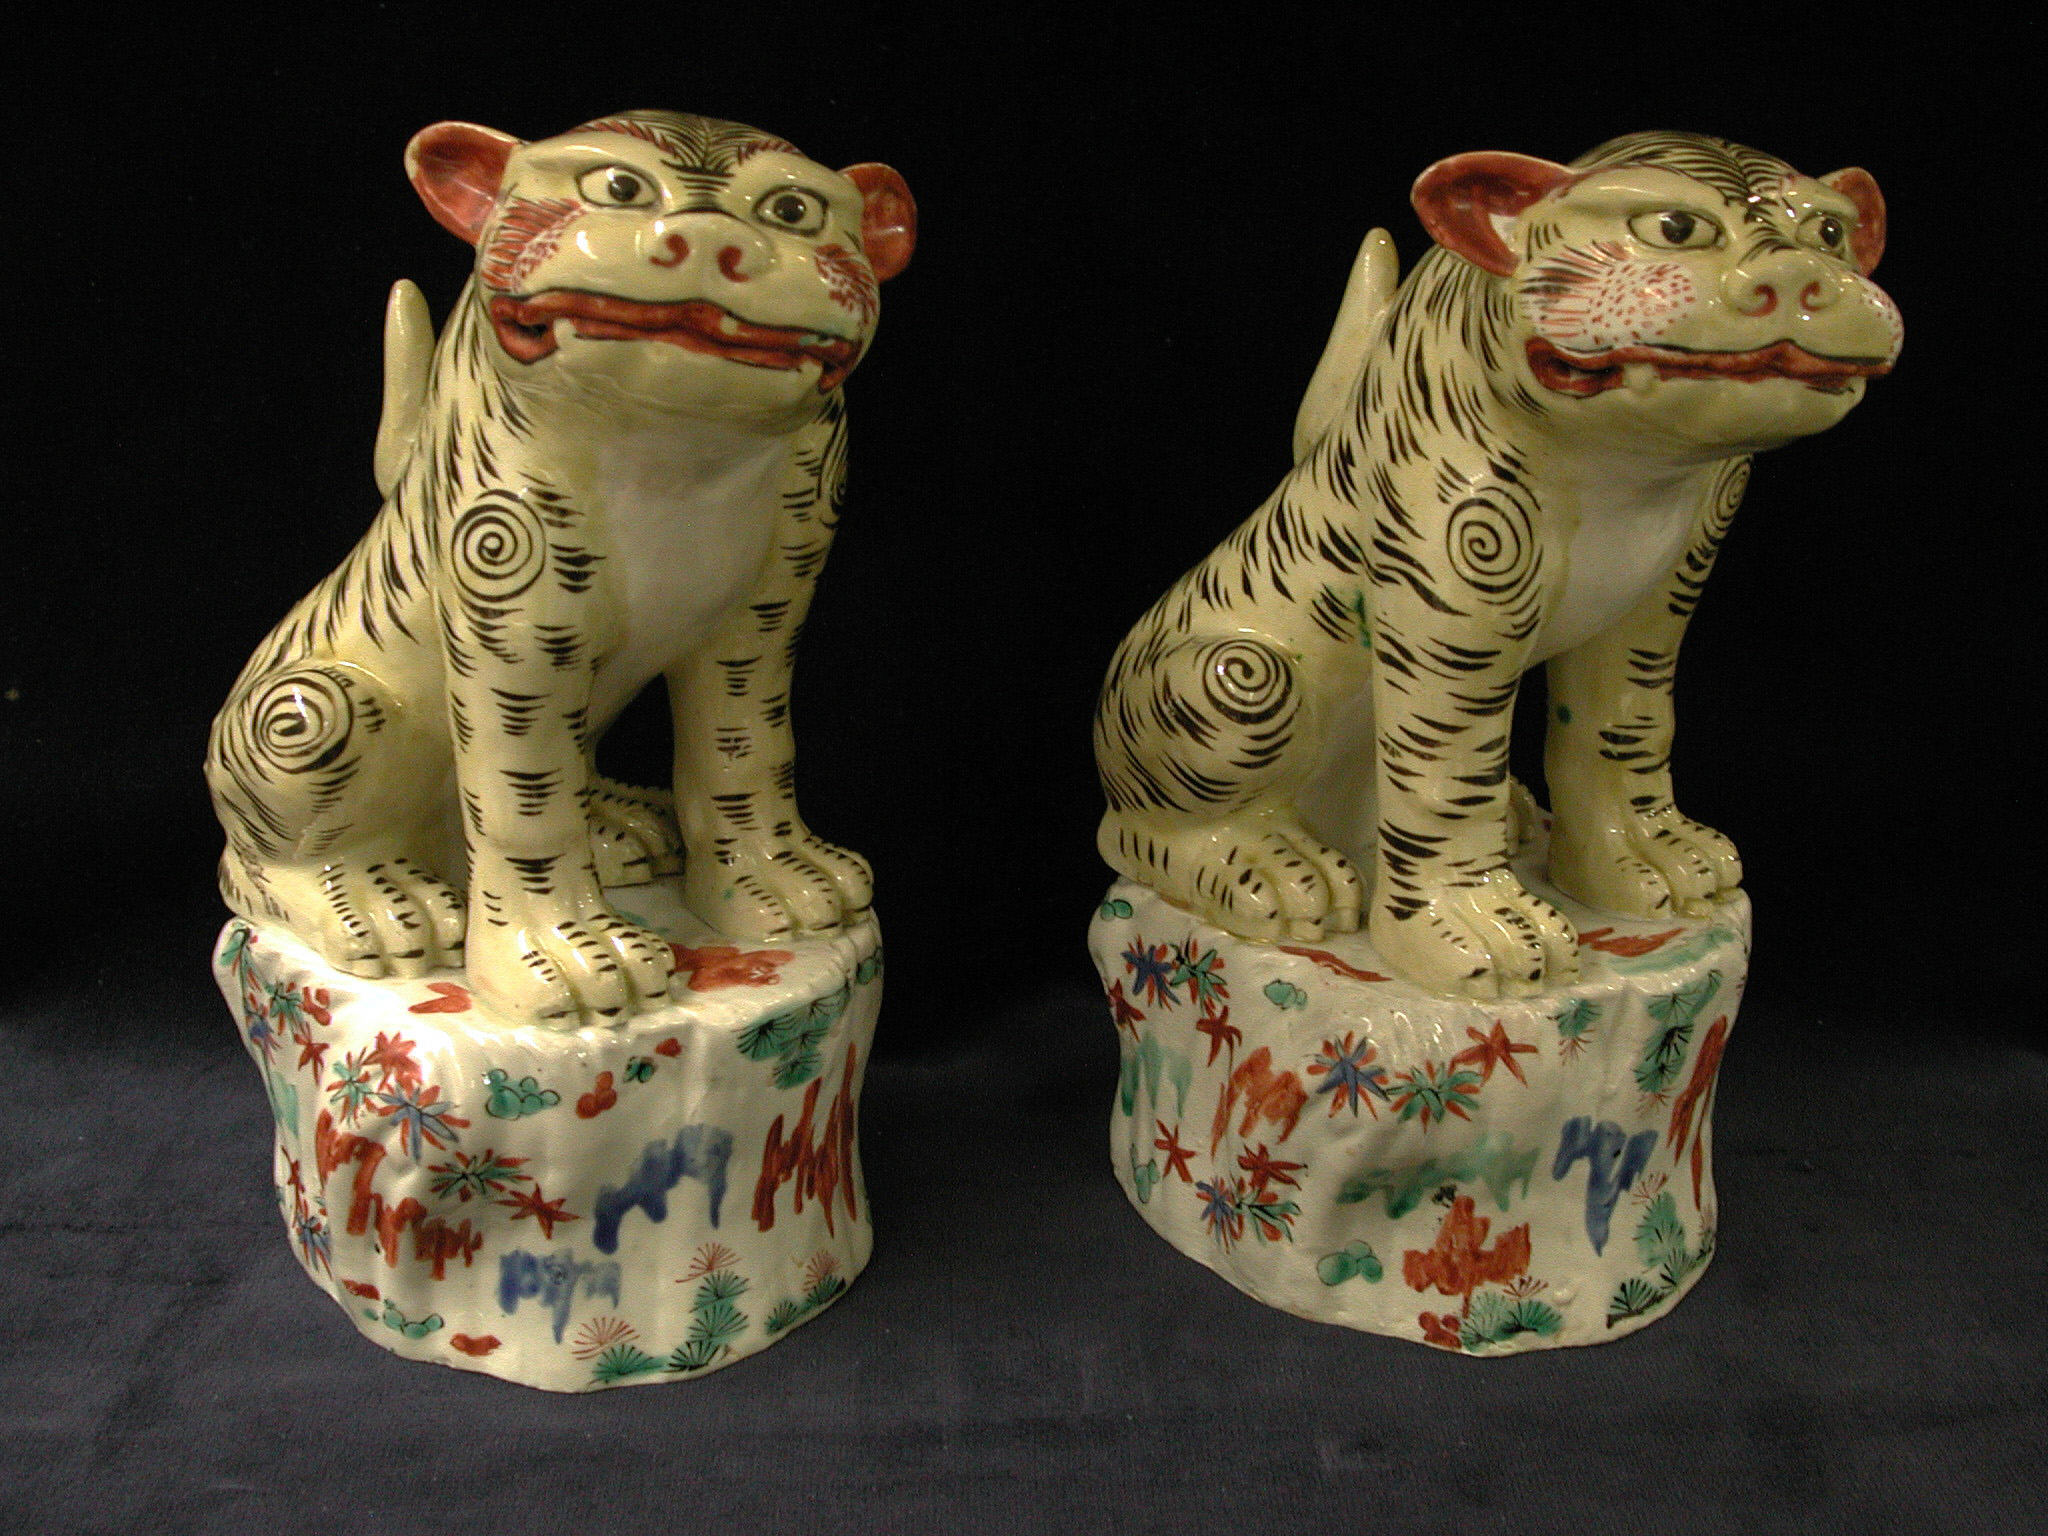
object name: figure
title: Two tigers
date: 1667-1700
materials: porcelain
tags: tigers